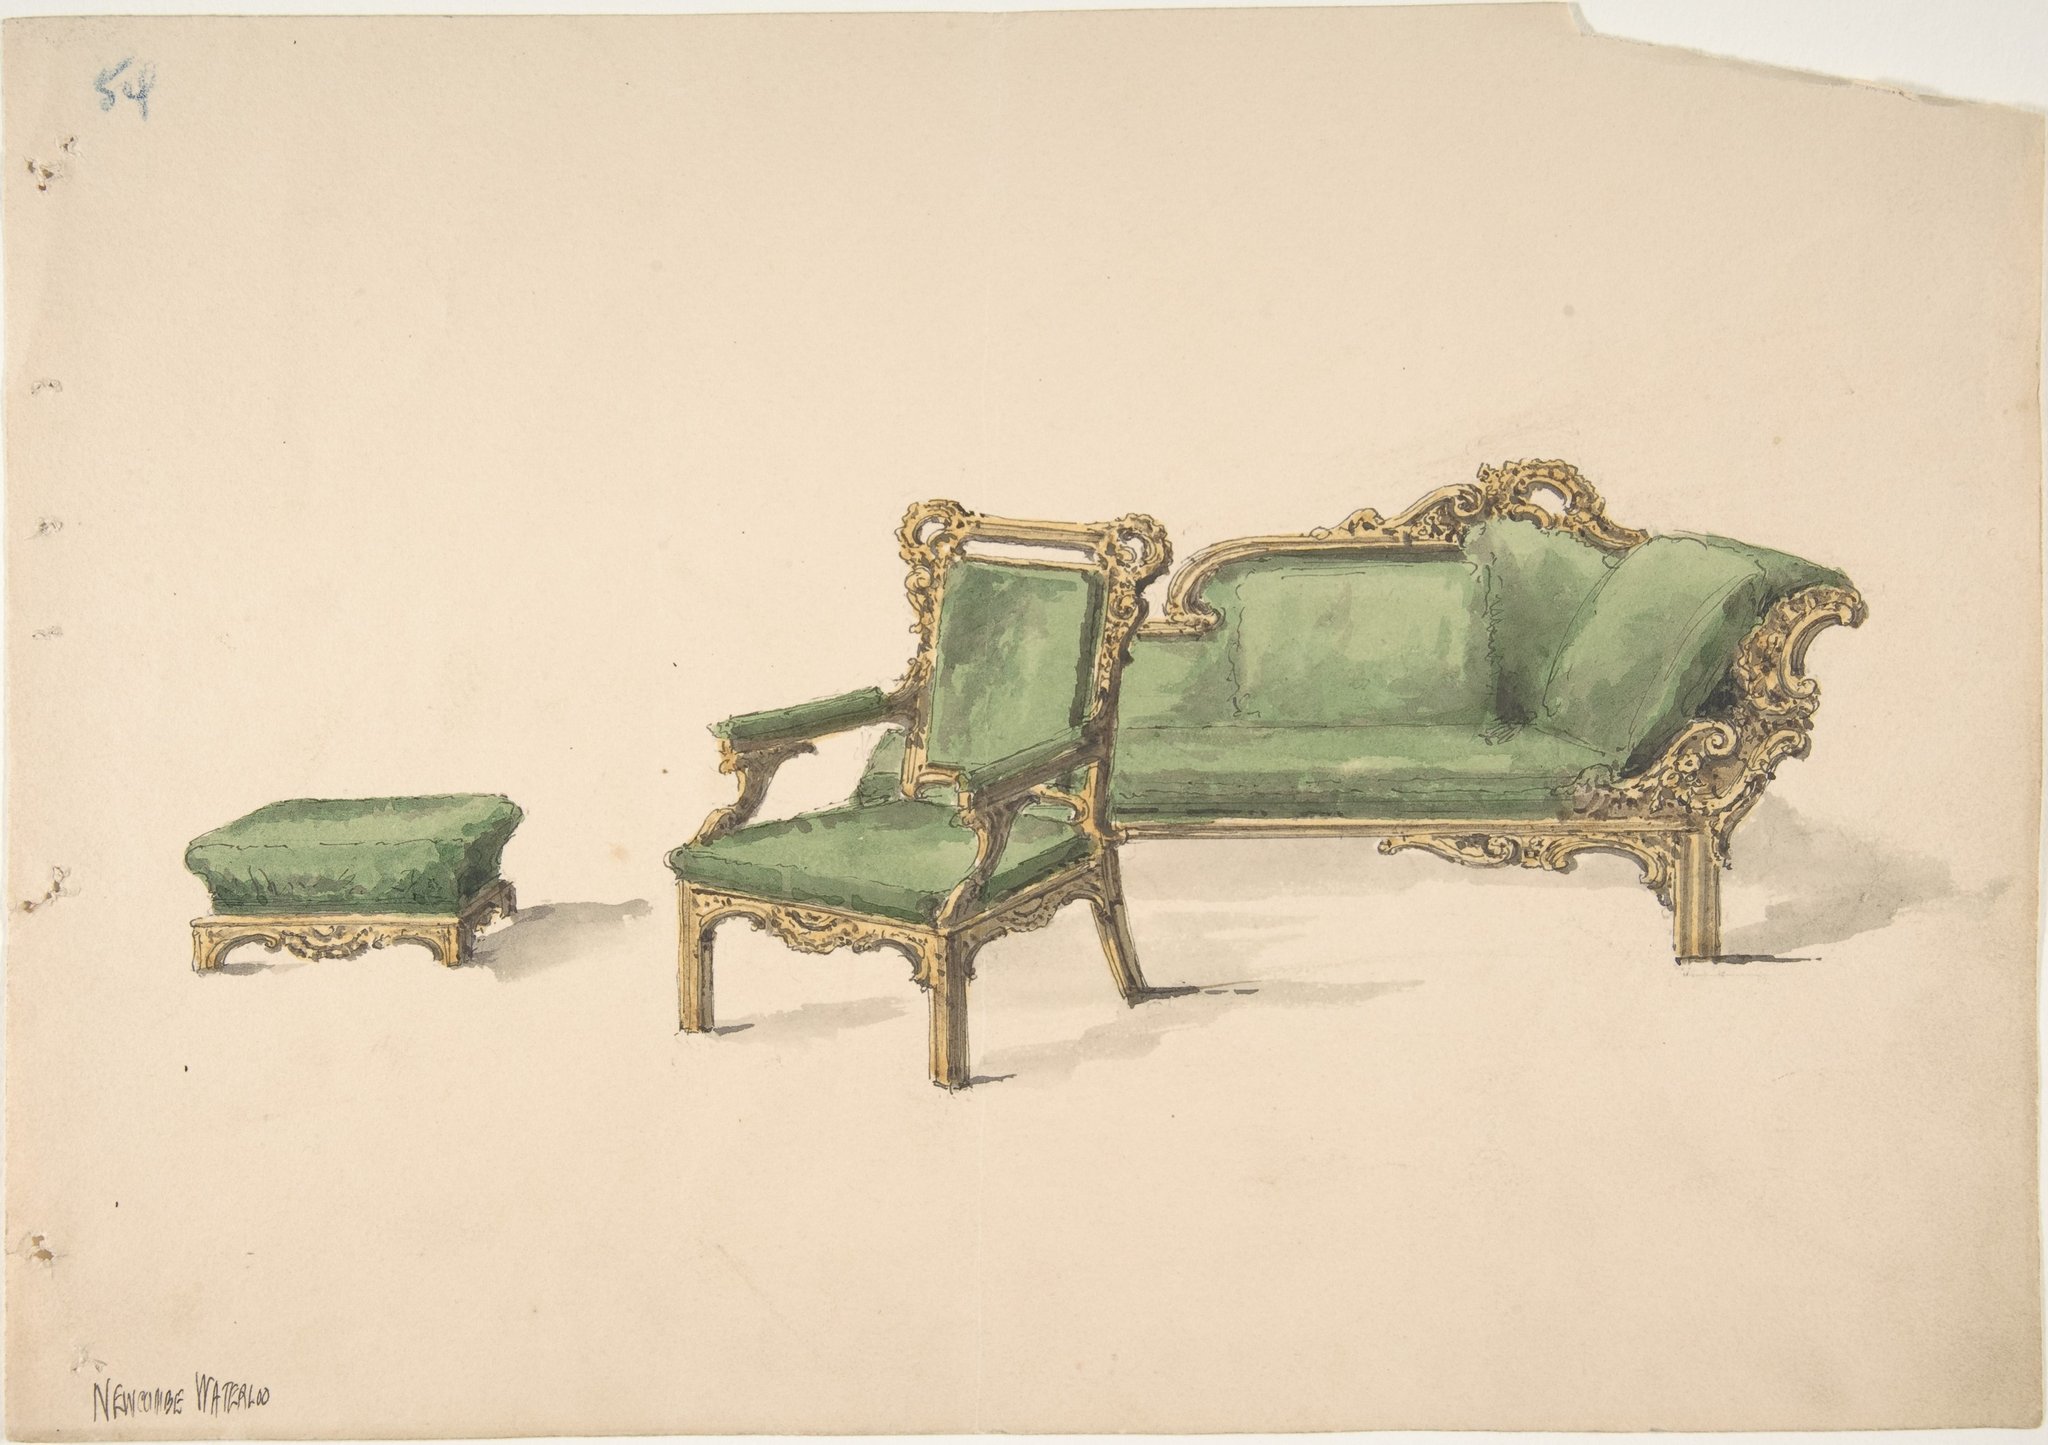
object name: drawing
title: Design for a Gilded Settee, Arm Chair and Footstool with Green Upholstery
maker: anonymous, british, 19th century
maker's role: artist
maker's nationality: british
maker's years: 1800-1900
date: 1801-1833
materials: ink, watercolor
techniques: brush, pen, wash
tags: chairs,couches,stools